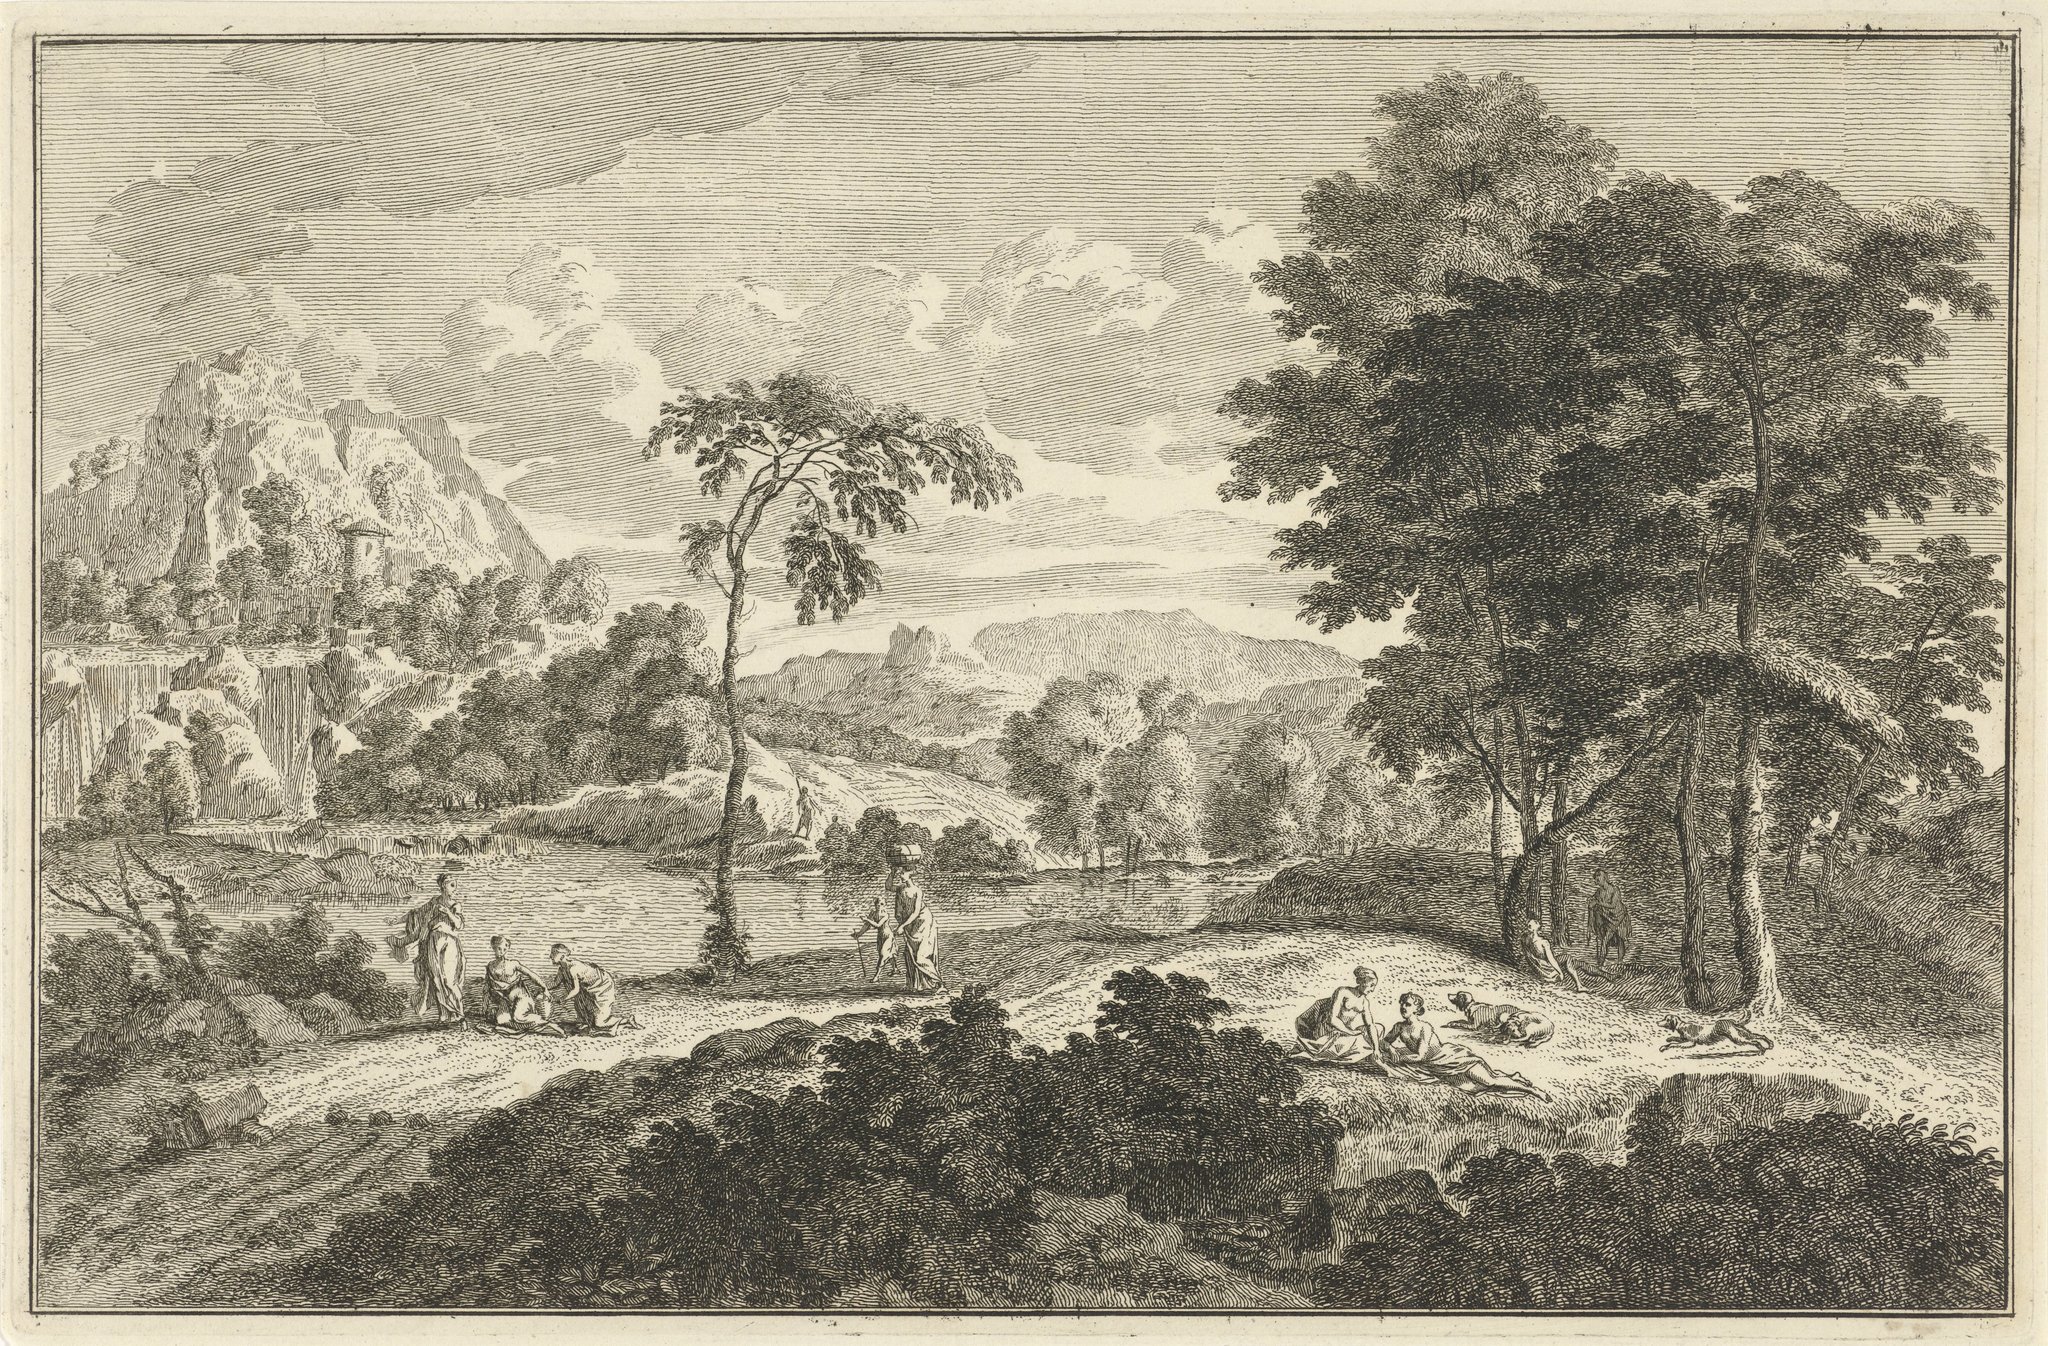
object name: print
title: Arcadisch rivierlandschap met waterval en diverse figuurgroepen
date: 1710-1747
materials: paper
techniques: etching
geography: amsterdam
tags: cattle, waterfall, landscapes with waters, waterscapes, seascapes (in the temperate zone), prospect of city, town panorama, silhouette of city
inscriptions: collector's mark: Lugt 240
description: Prent kan mogelijk deel uitmaken van een dertigdelige serie prenten met voorstellingen van Italiaanse en Duitse landschappen, eveneens naar ontwerp van Johannes Glauber. Niet vermeld in literatuur. Titelprent in RPK.